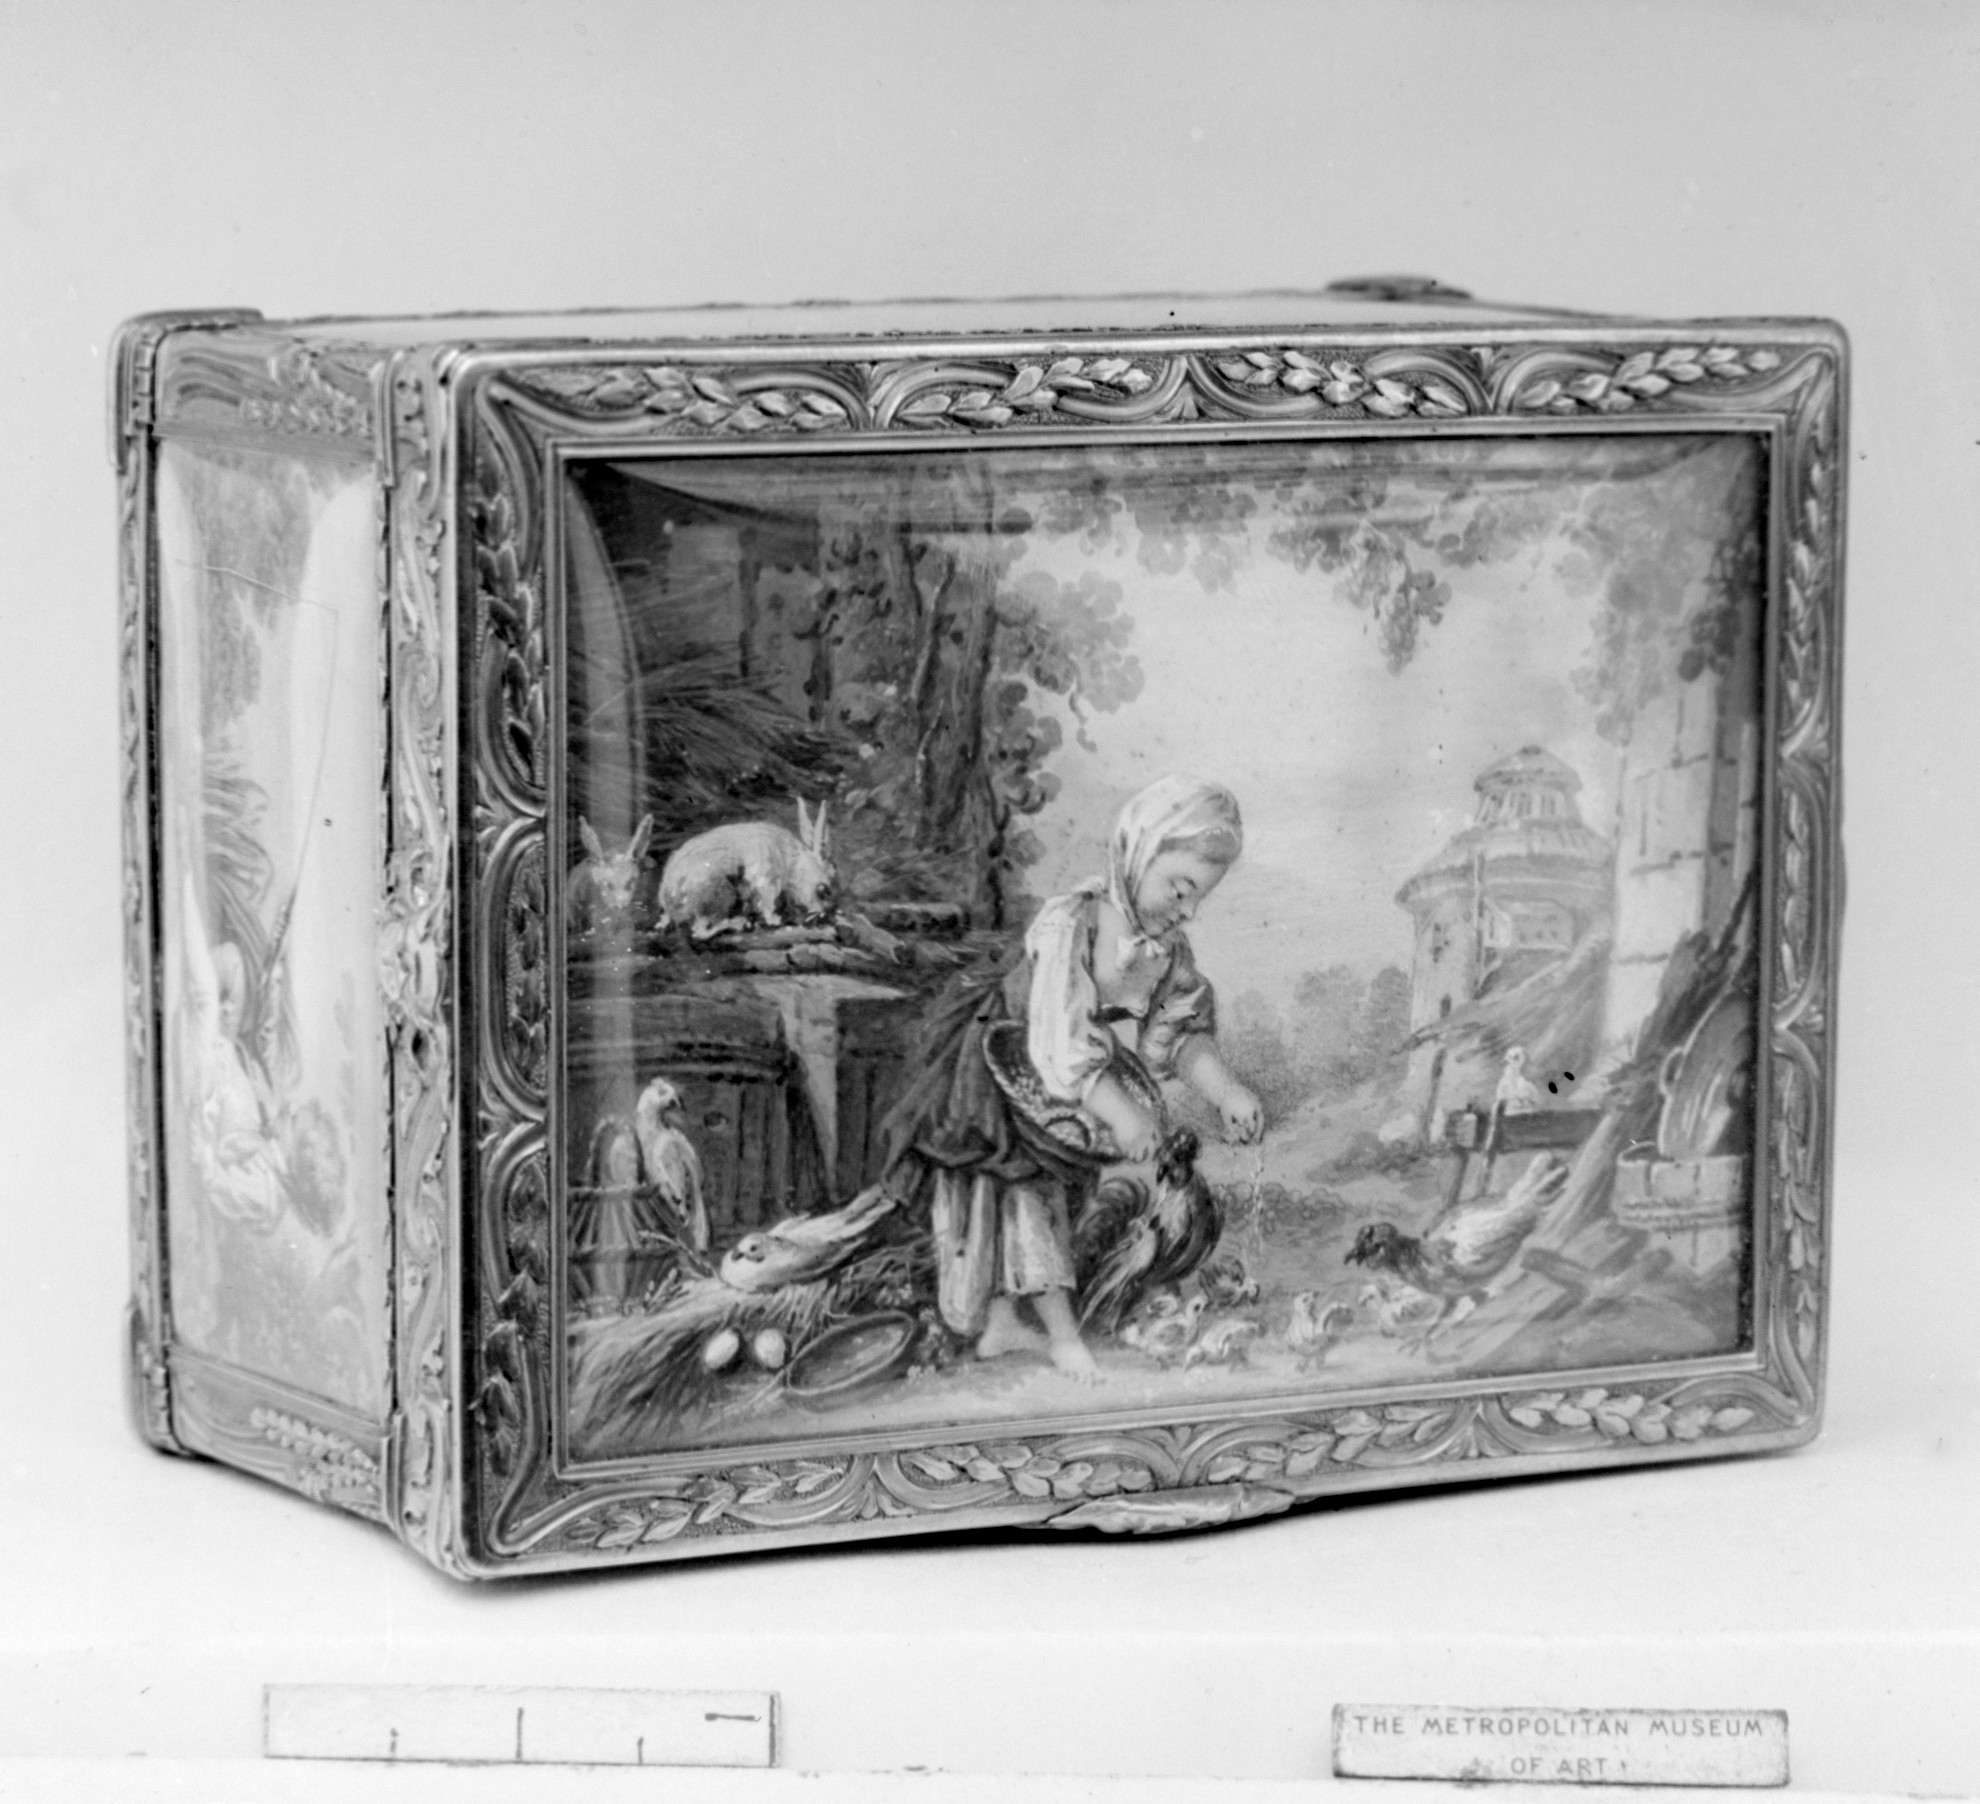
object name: snuffbox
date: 1801-1900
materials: gold, ivory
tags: birds,chickens,girls,rabbits